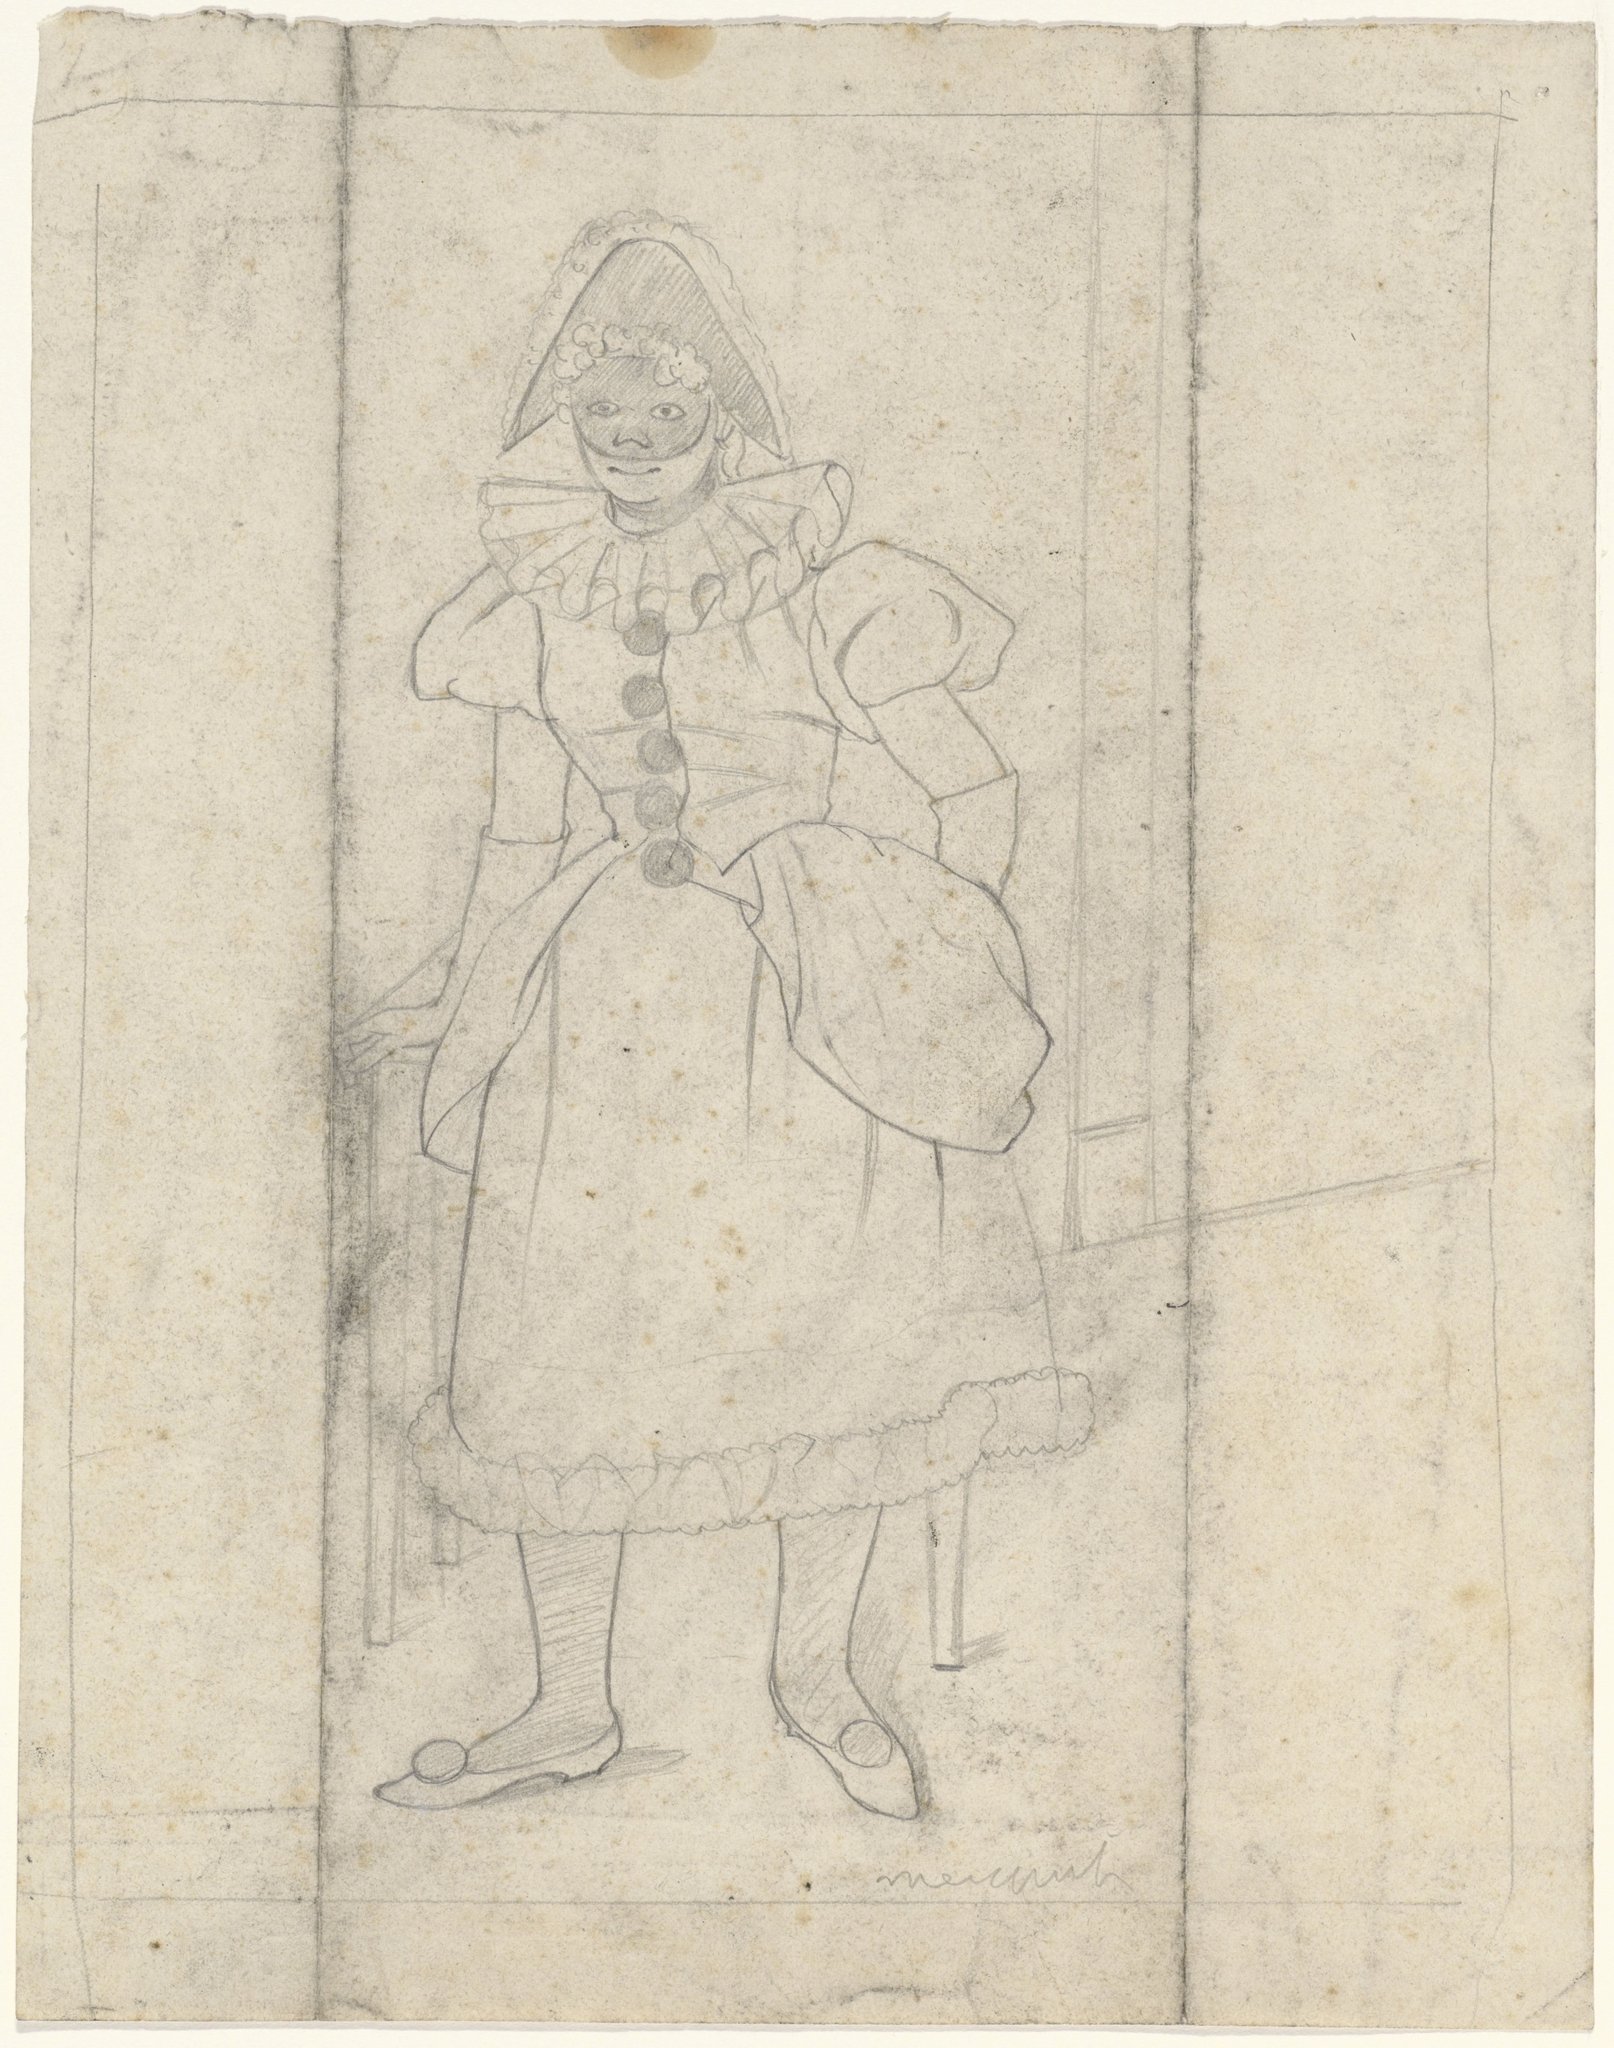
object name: drawing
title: Staande vrouwelijke carnavalsfiguur, met masker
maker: samuel jessurun de mesquita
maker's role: draughtsman, print maker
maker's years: 1868-1944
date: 1878-1944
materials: paper, pencil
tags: types in 'commedia dell'arte', stage costume